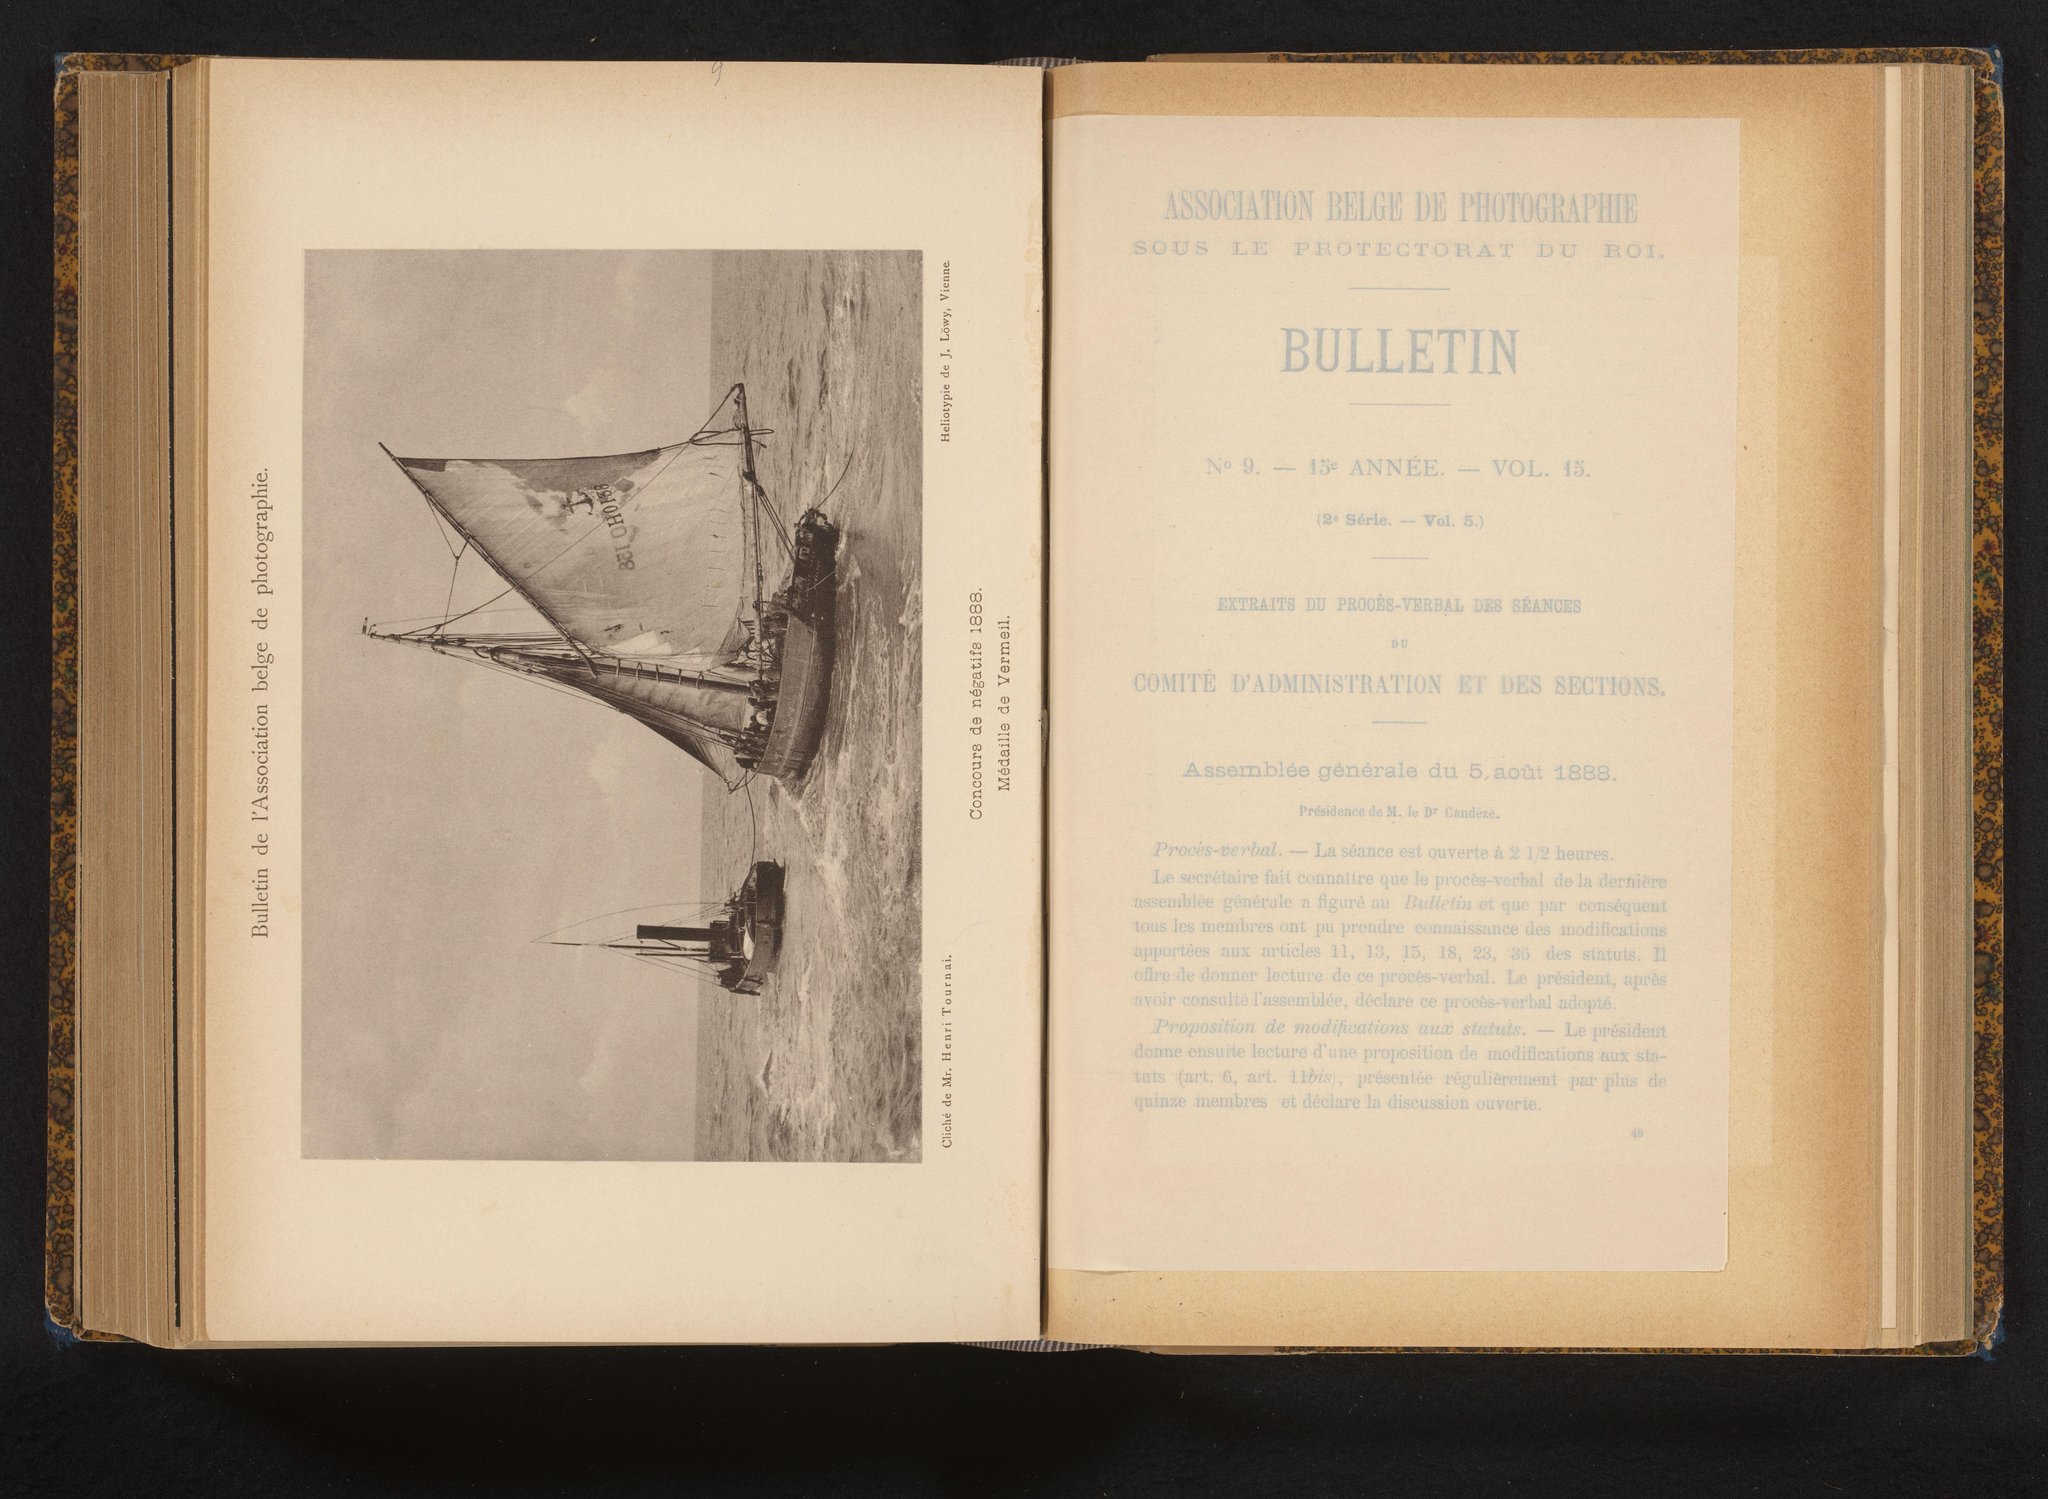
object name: photomechanical print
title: Zeegezicht met zeilschip en sleepboot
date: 1883-1888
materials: cardboard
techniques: heliotype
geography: vienna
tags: sailing-ship, sailing-boat, sea (seascape), tug, pusher tug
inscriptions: inscription: ‘Concours de négatifs 1888./ Médaille de Vermeil.’